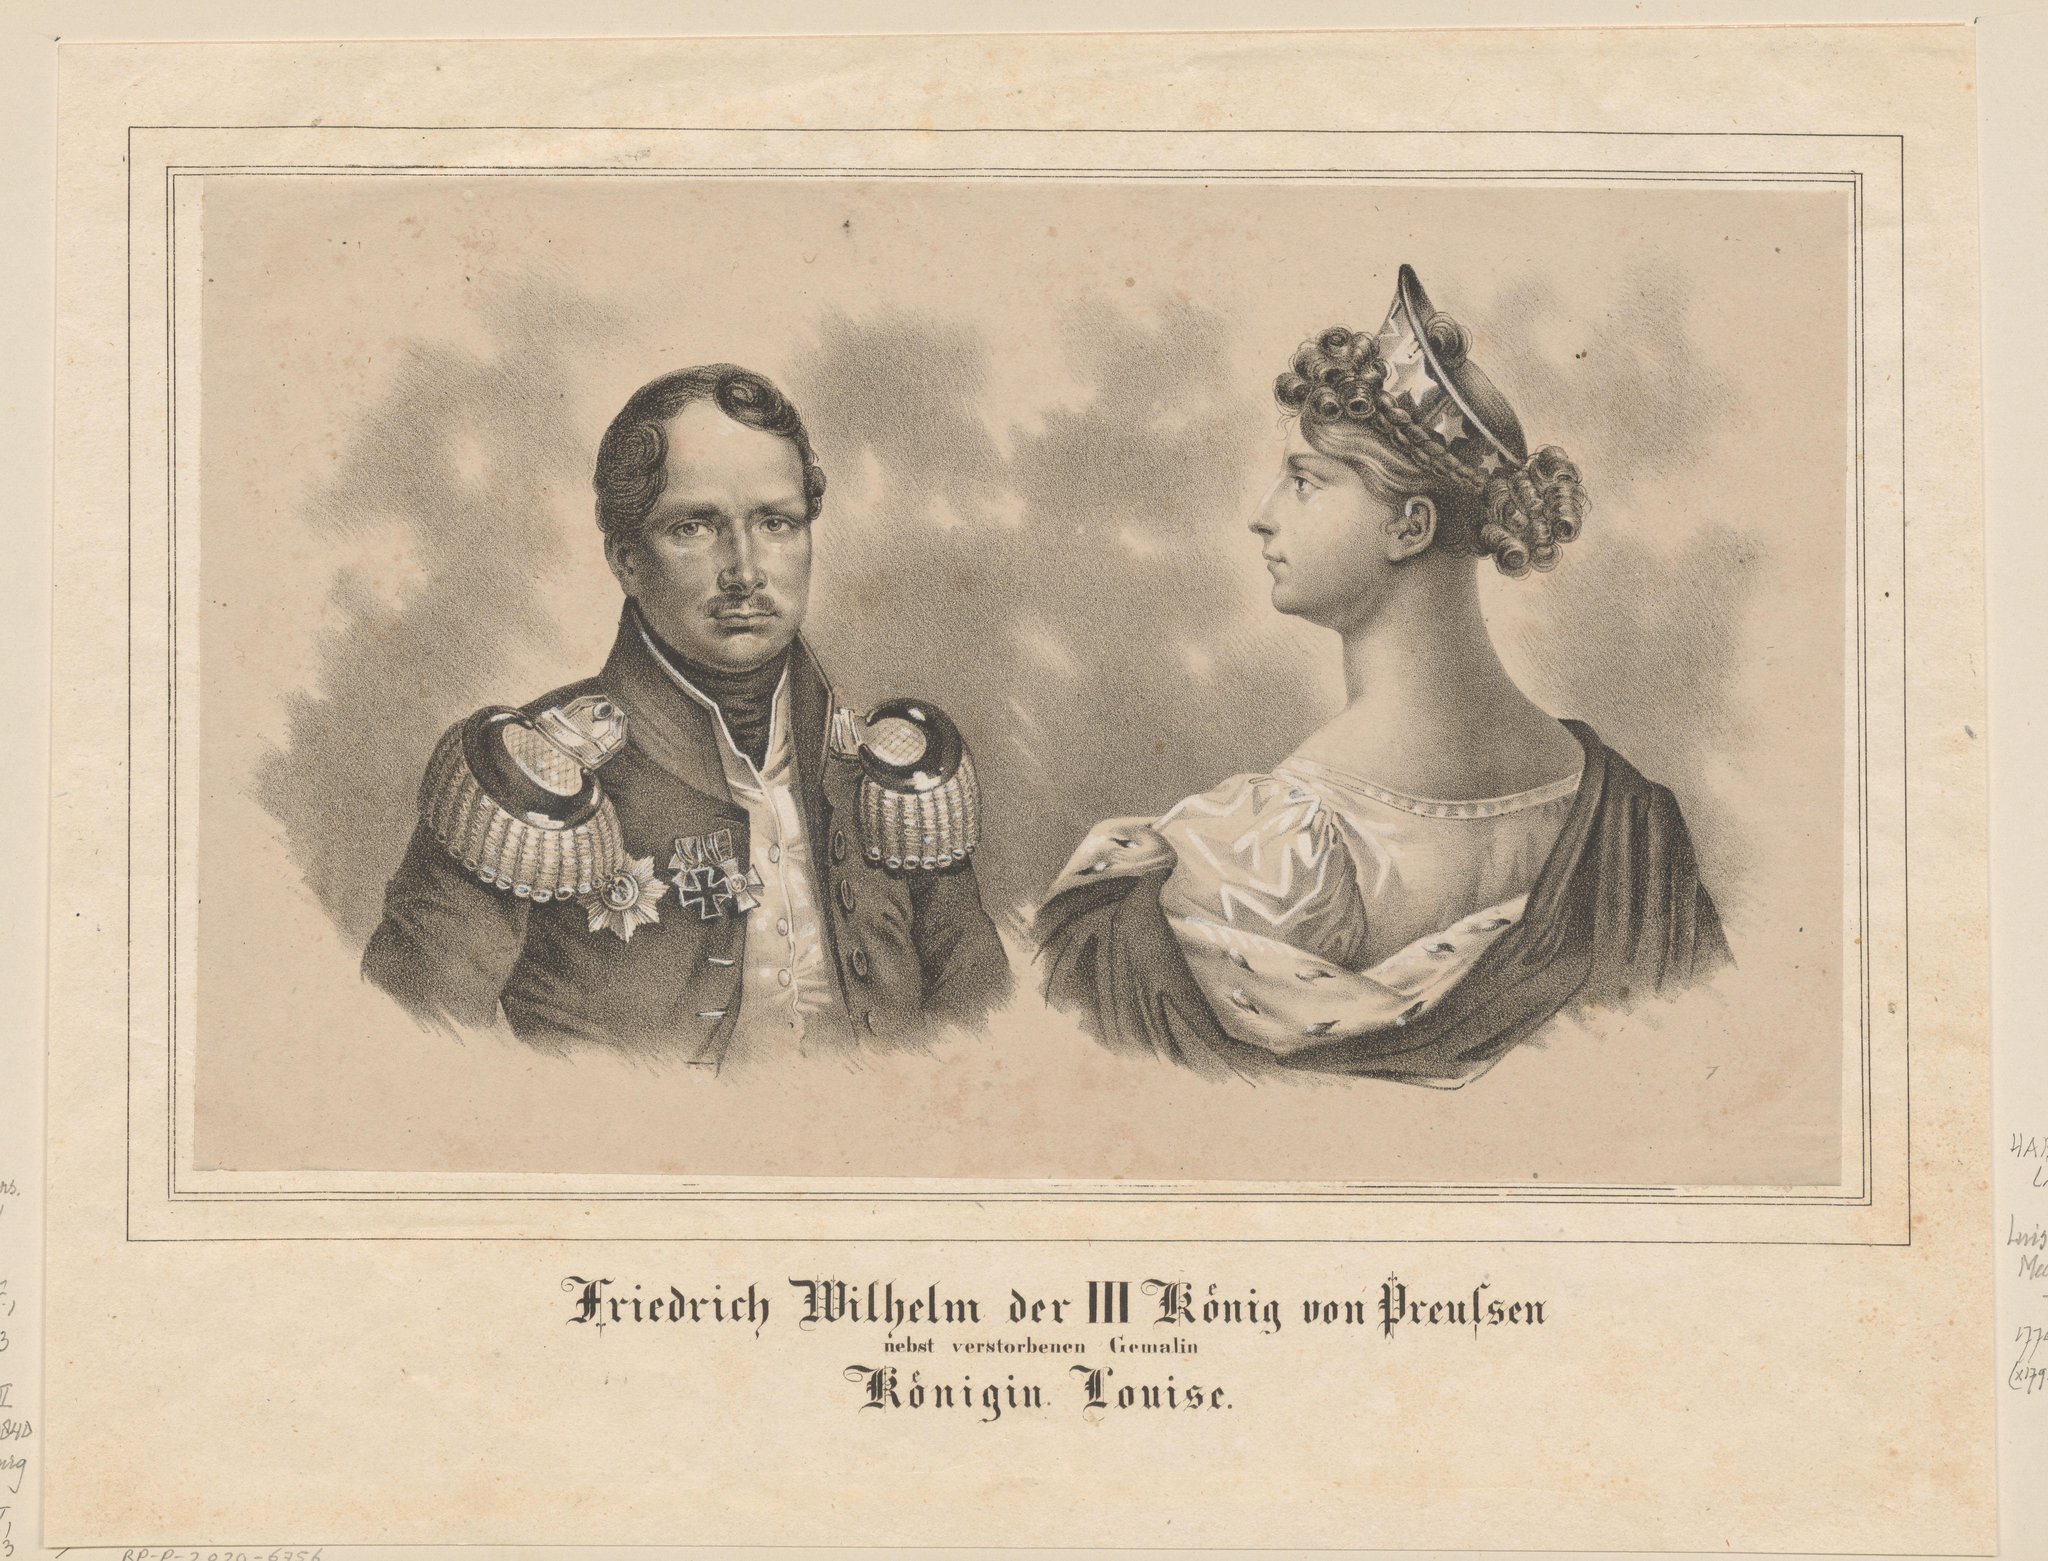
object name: print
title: Dubbelportret van Frederik Willem III van Pruisen en Louise van Mecklenburg-Strelitz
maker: Anonymous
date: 1810-1840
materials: paper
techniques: lithograph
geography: germany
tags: berlin, frederik willem iii koning van pruisen, historical person in a double portrait, historical person - woman - in a double portrait, queen, king